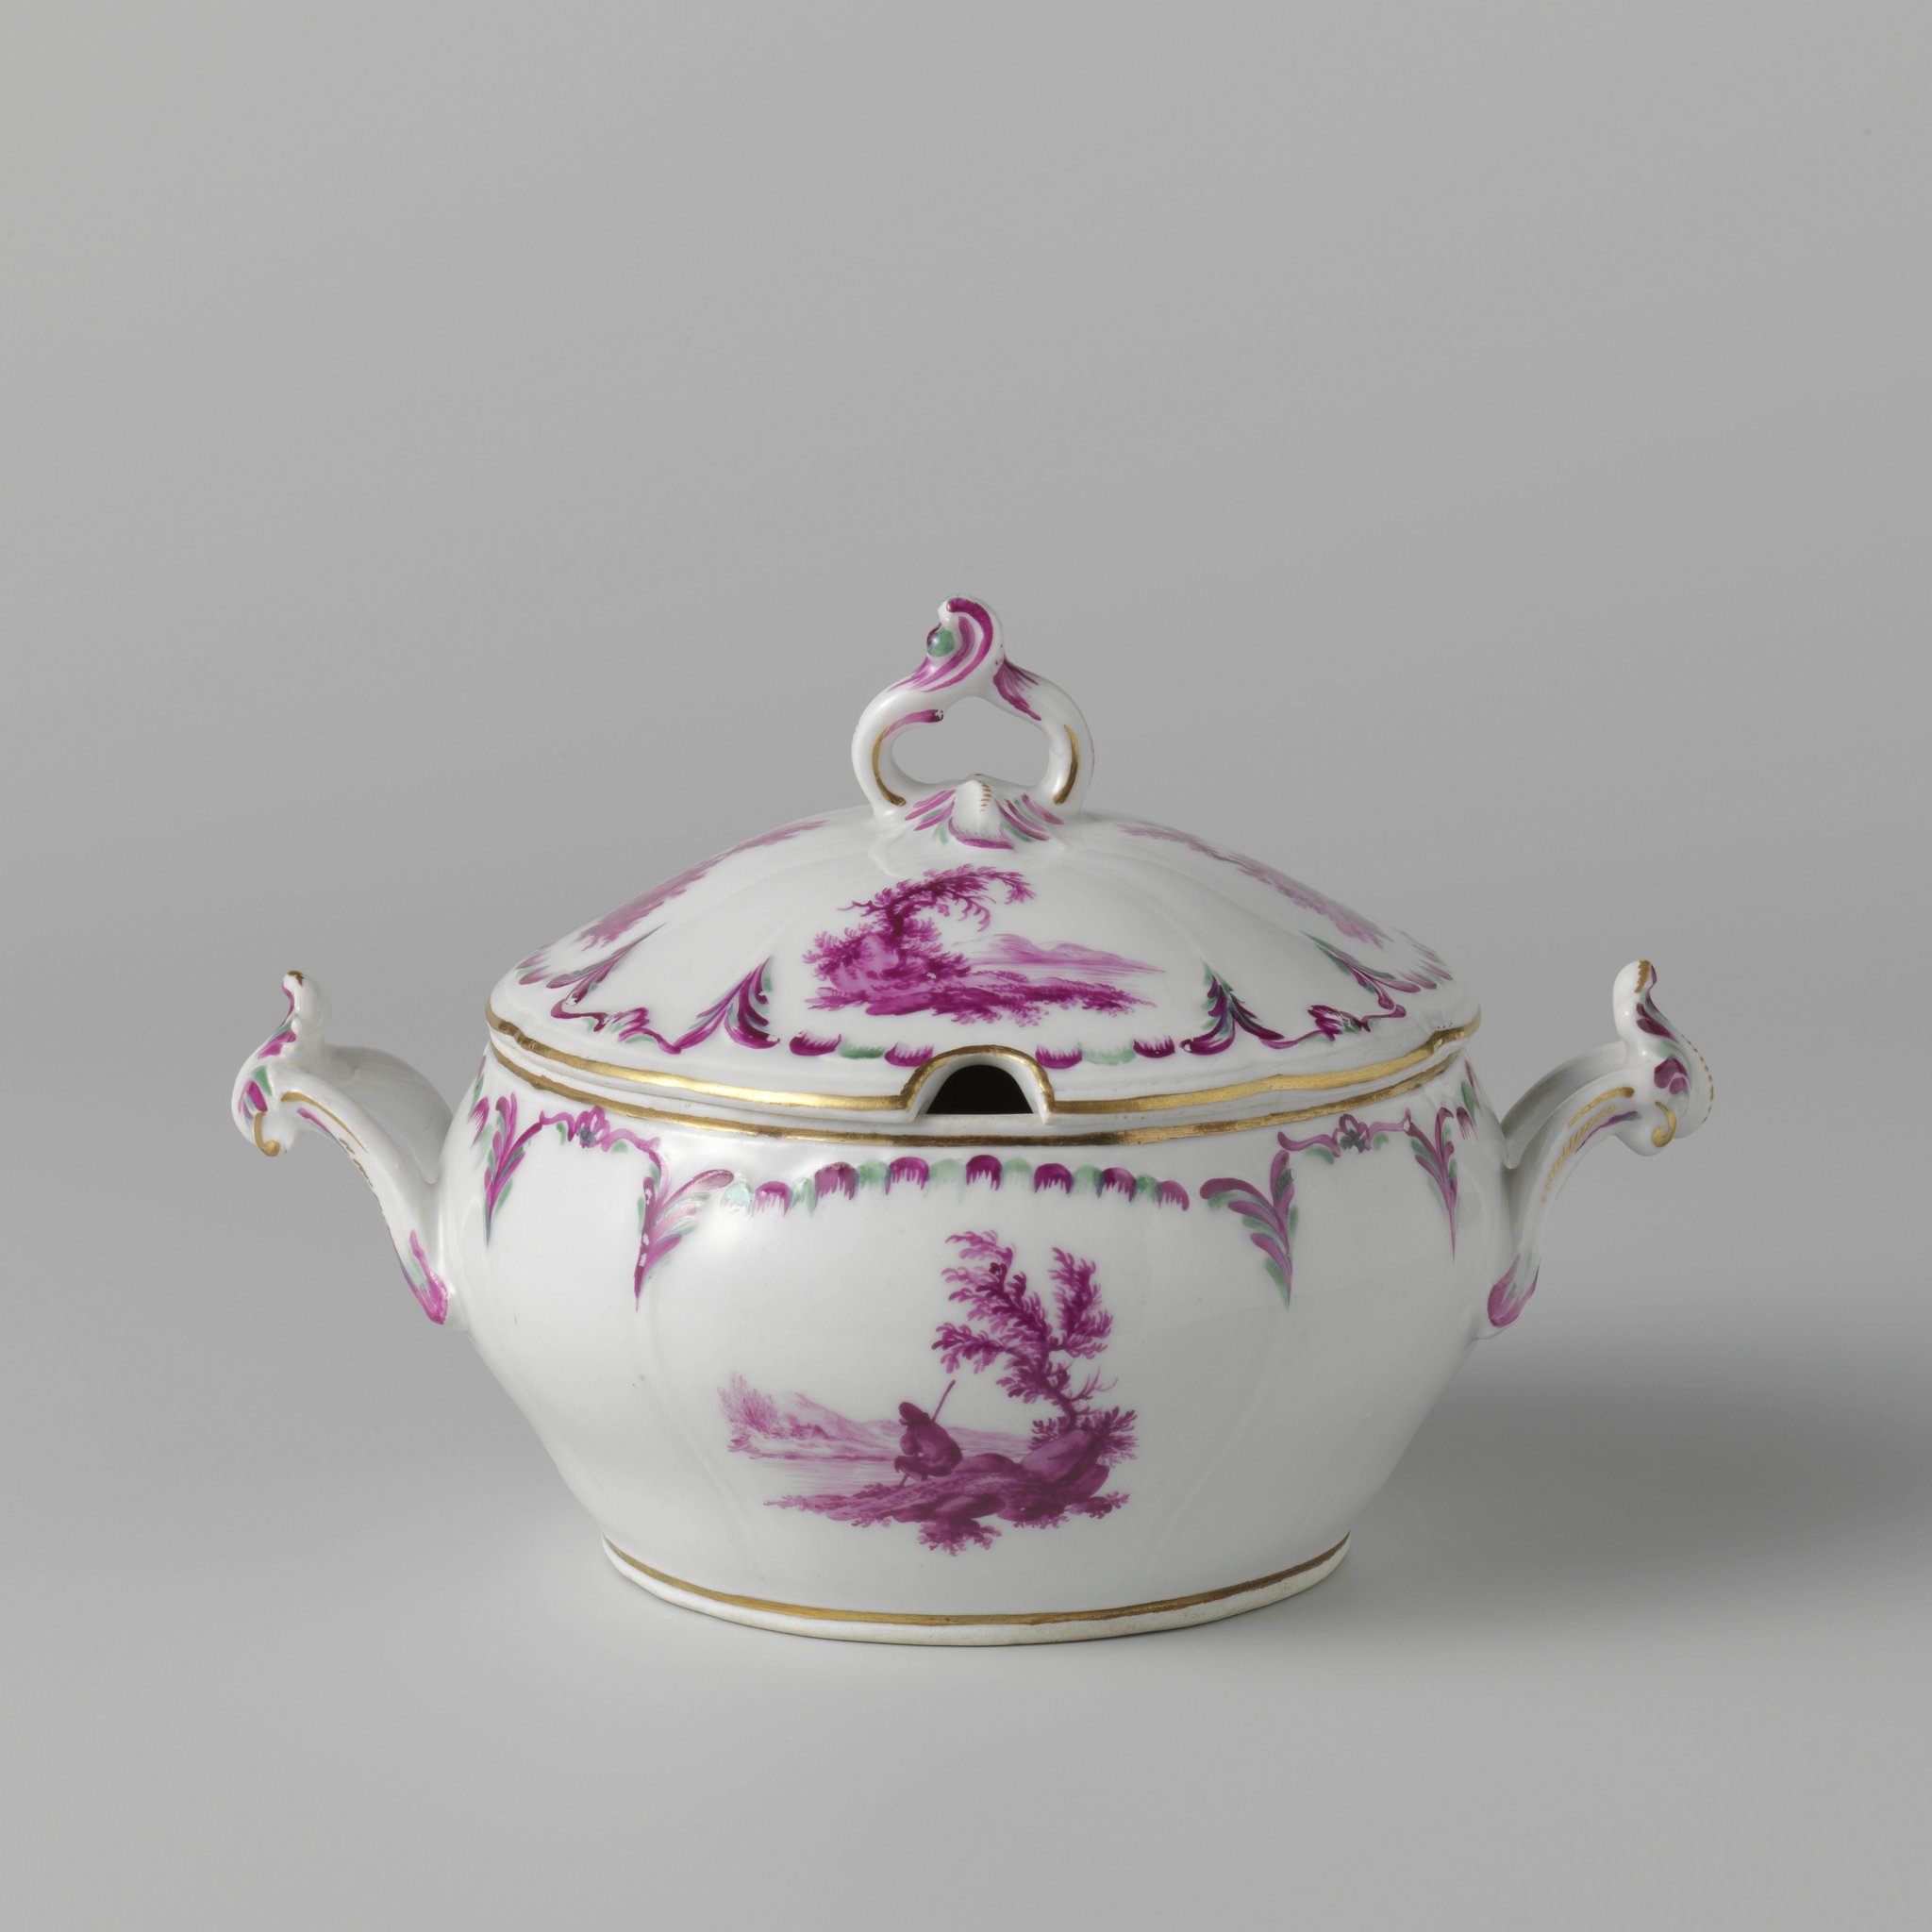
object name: tureen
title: Tureen and stand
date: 1778-1782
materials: porcelain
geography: loosdrecht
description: Manufactuur Oud-Loosdrecht Loosdrecht, c. 1778–1782 hard-paste porcelain